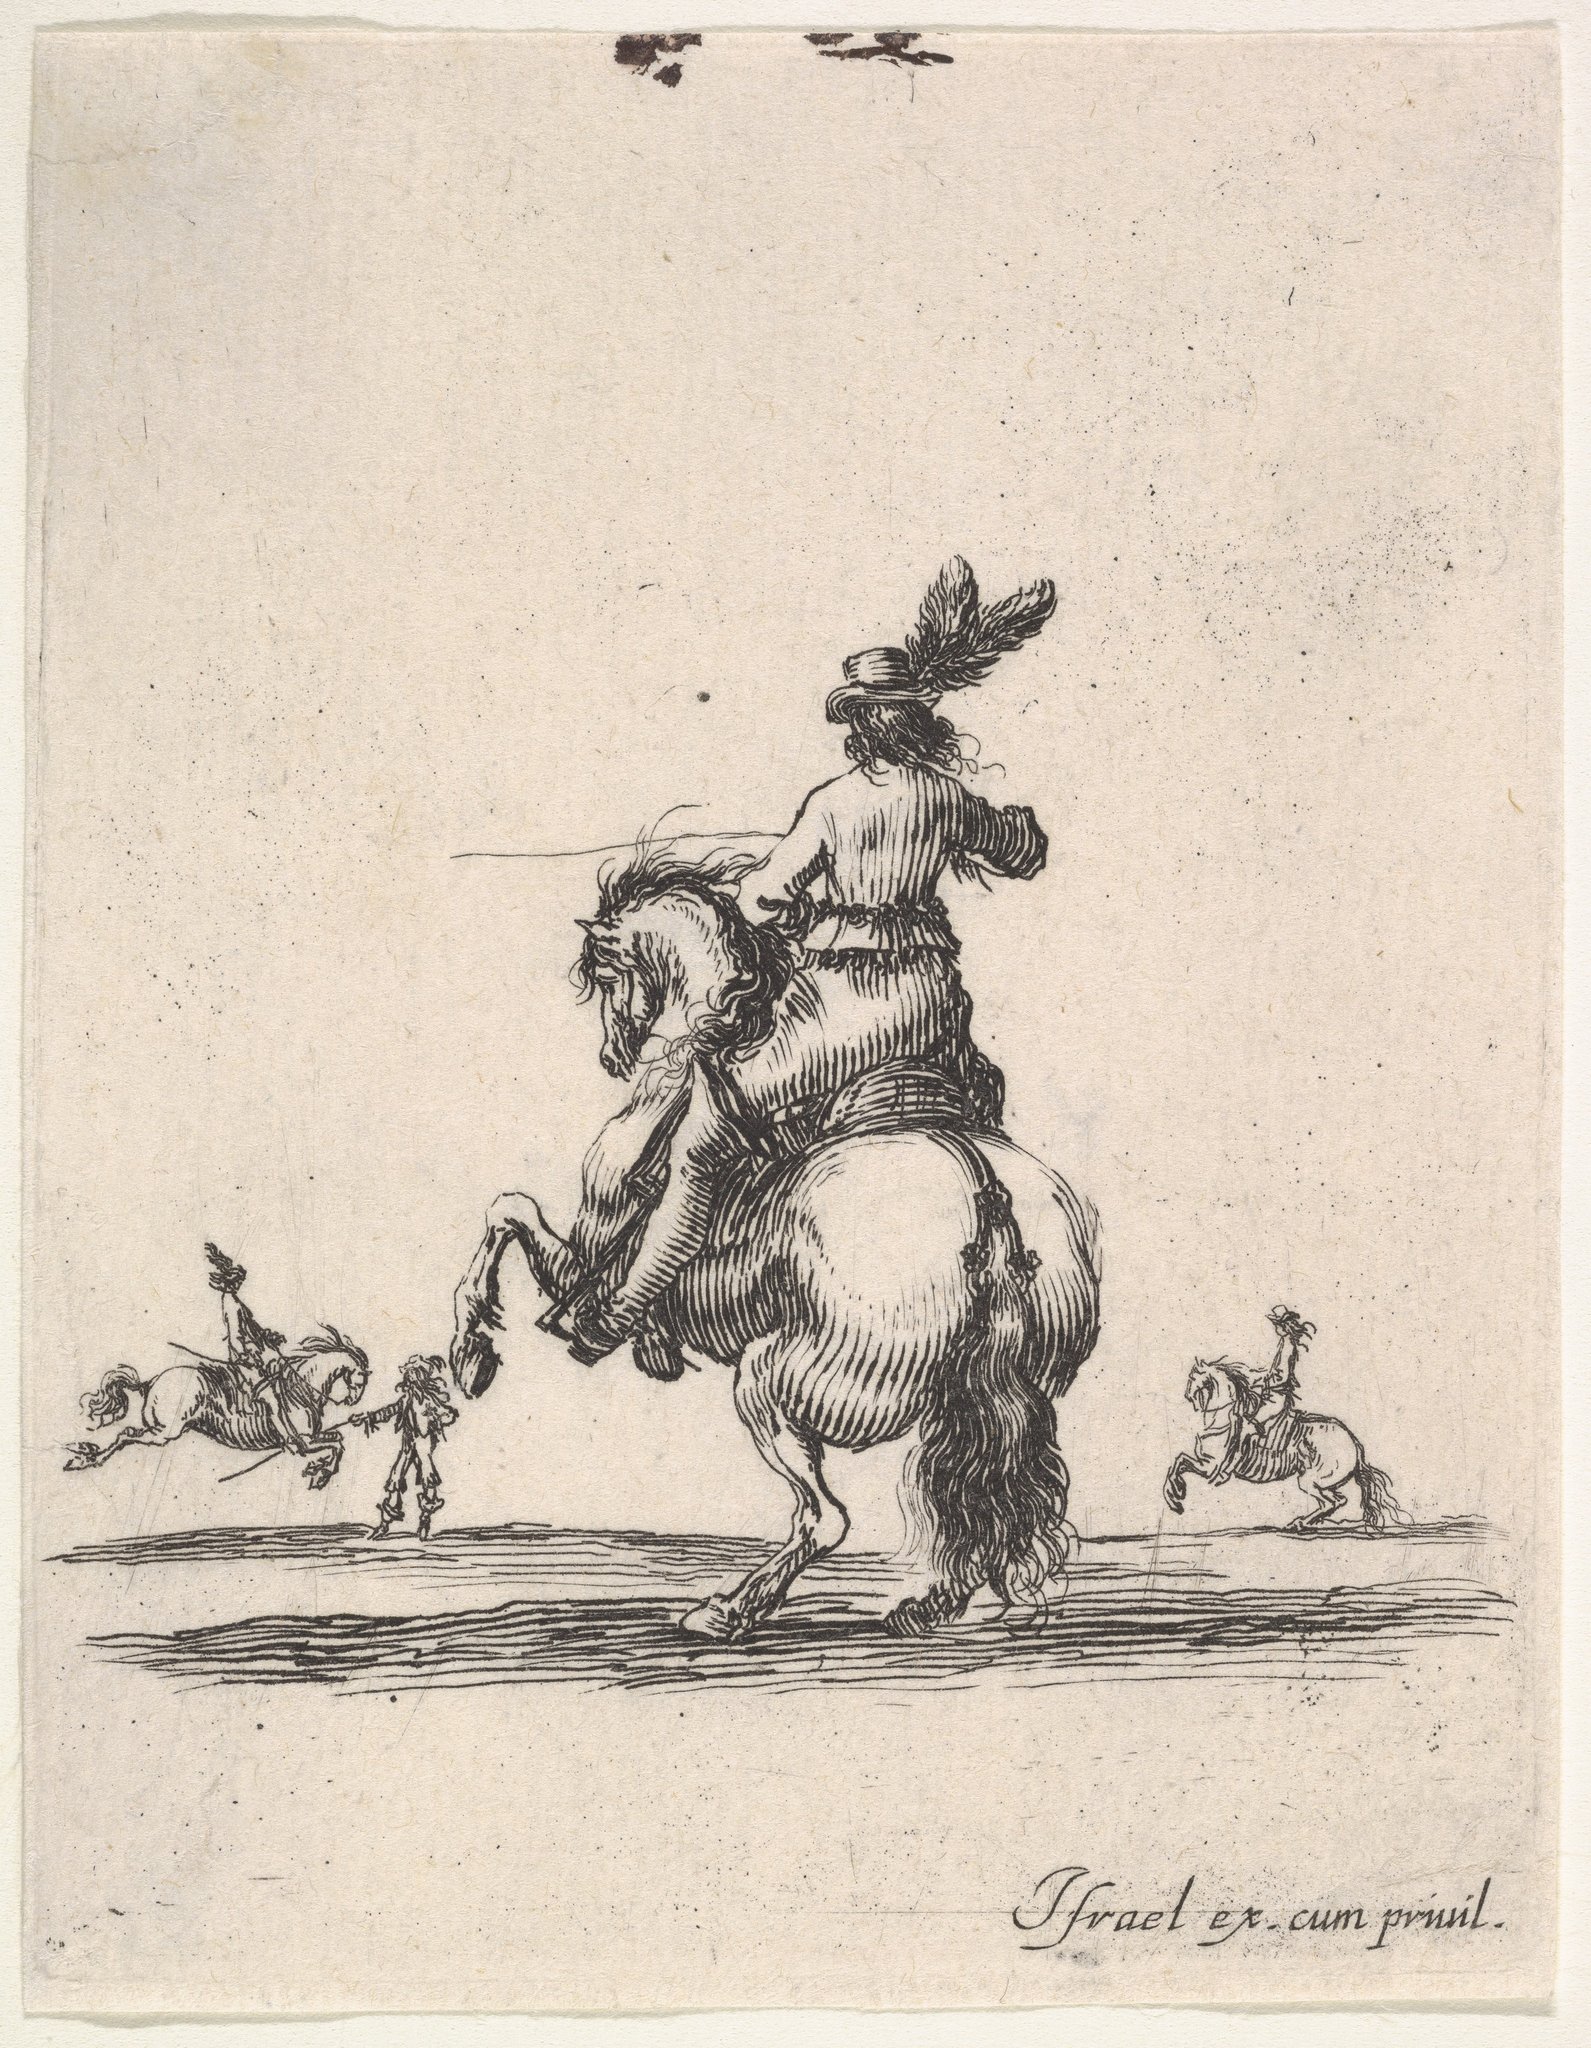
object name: print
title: A horseman atop a rearing horse, seen from behind and turned towards the left, two horsemen in the background, from "Various cavalry exercises" (Diverses exercices de cavalerie)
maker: stefano della bella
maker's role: artist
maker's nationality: italian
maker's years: 1610-1664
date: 1642-1645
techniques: etching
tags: men,horses